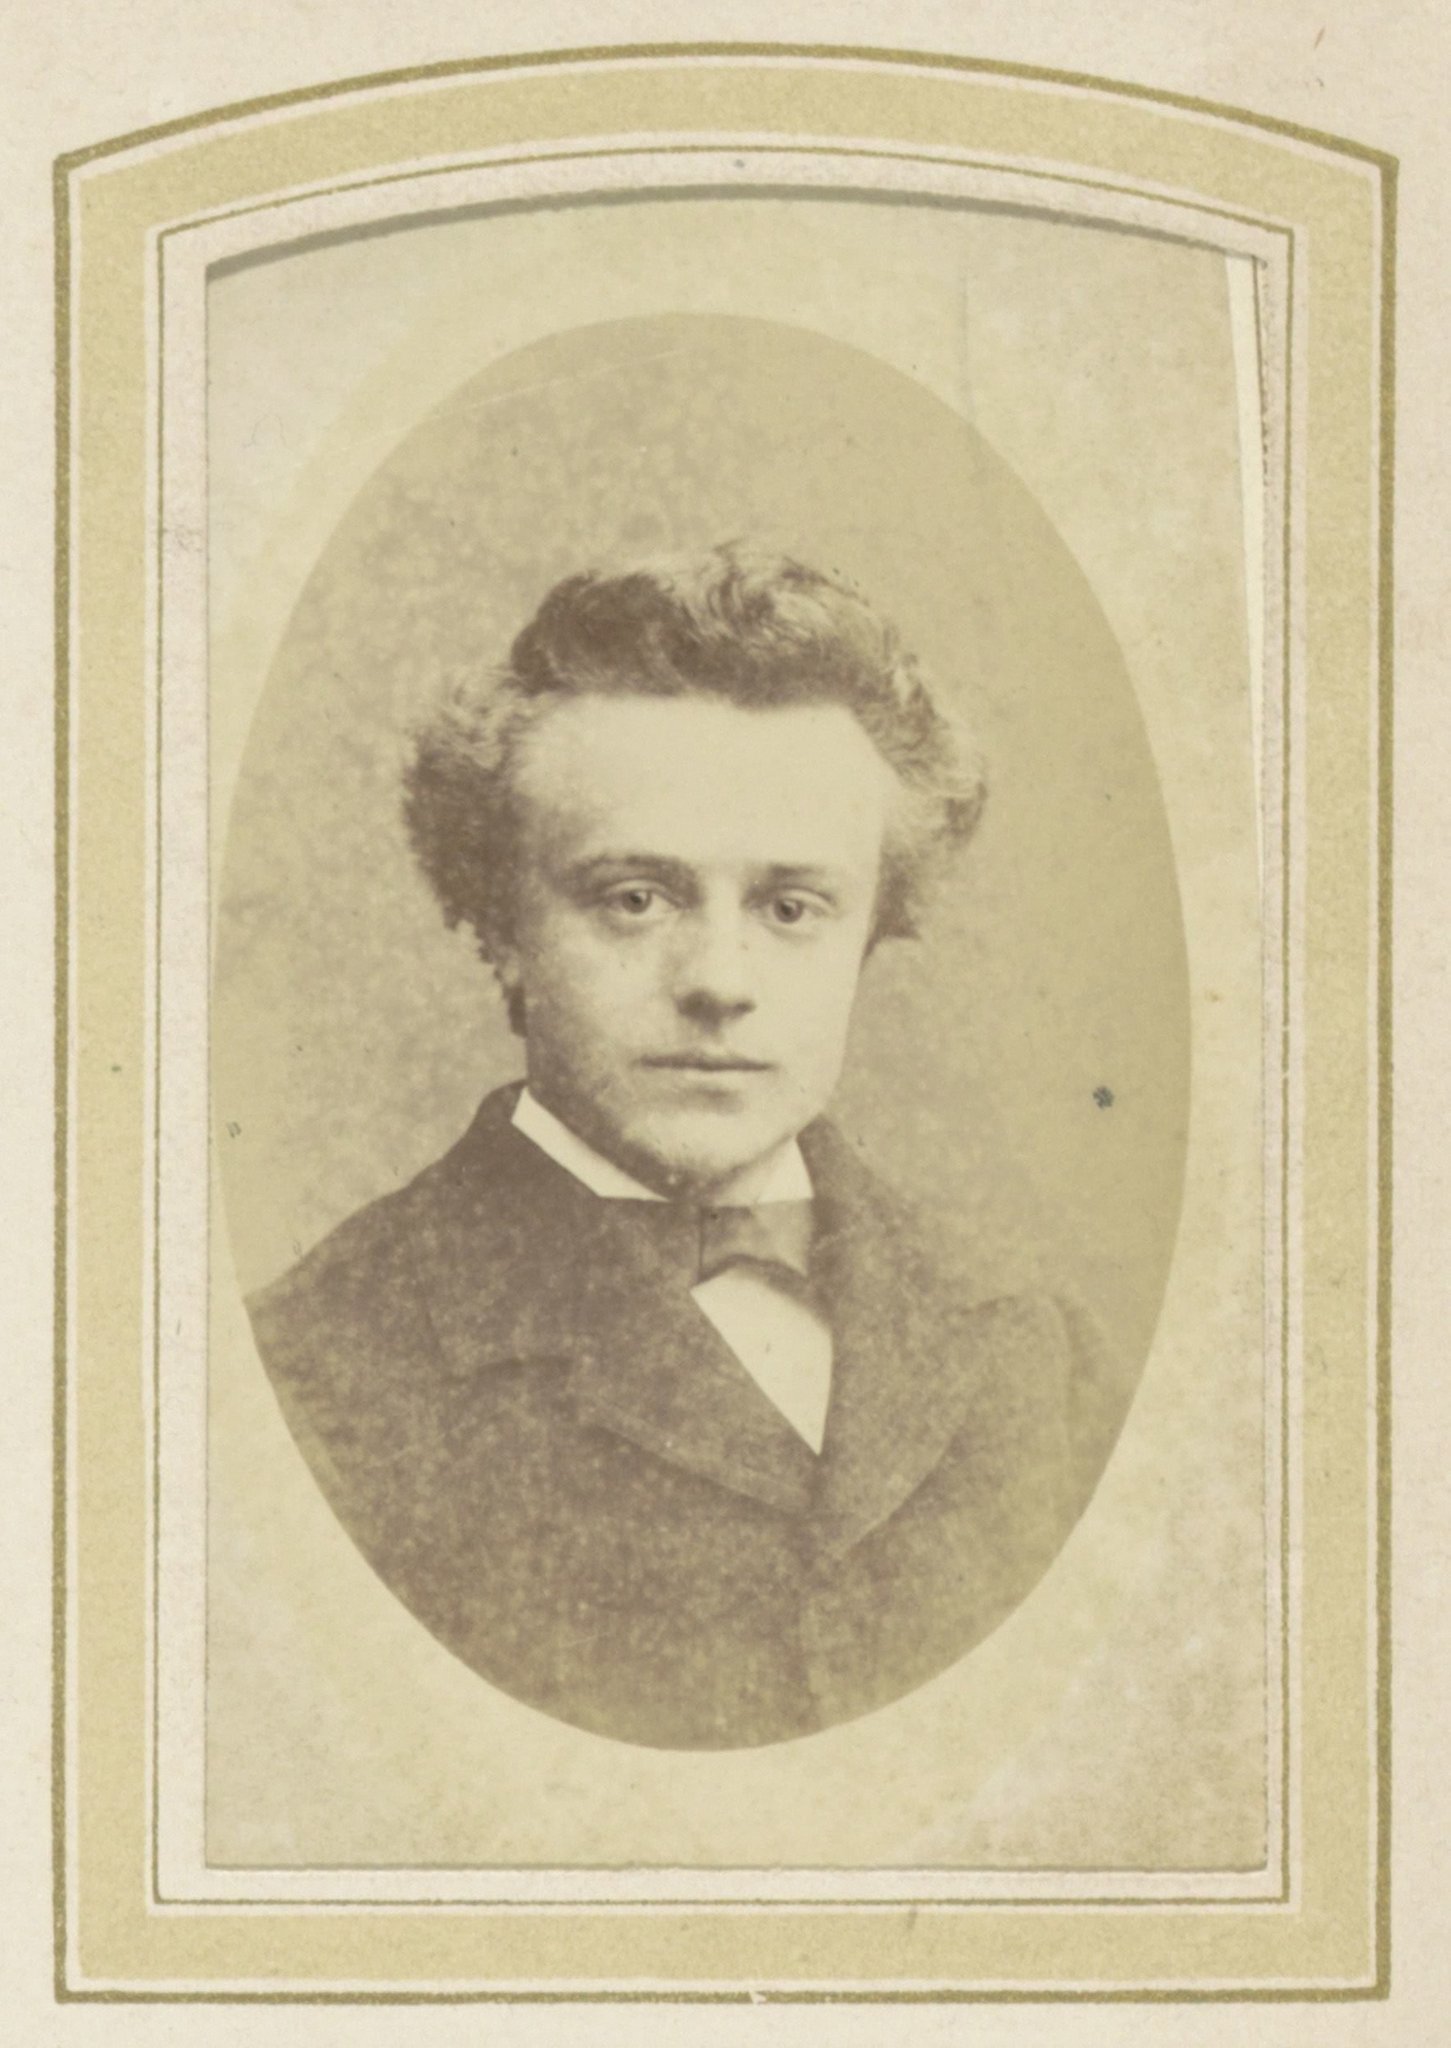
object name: photograph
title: Portret van een jongeman met een das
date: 1864-1887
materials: cardboard, paper, photographic support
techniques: albumen print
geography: netherlands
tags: historical persons, neck-gear ~ clothing, clothing for the upper part of the body, hairdress, netherlands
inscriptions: address: ‘Amsterdam Rokin over de Bank 138 Utrecht Hamburgerstraat F 237’, address: ‘Amsterdam-Utrecht’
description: Onderdeel van Fotoalbum van een Nederlandse familie met 168 cartes-de-visite en kabinetfoto's.